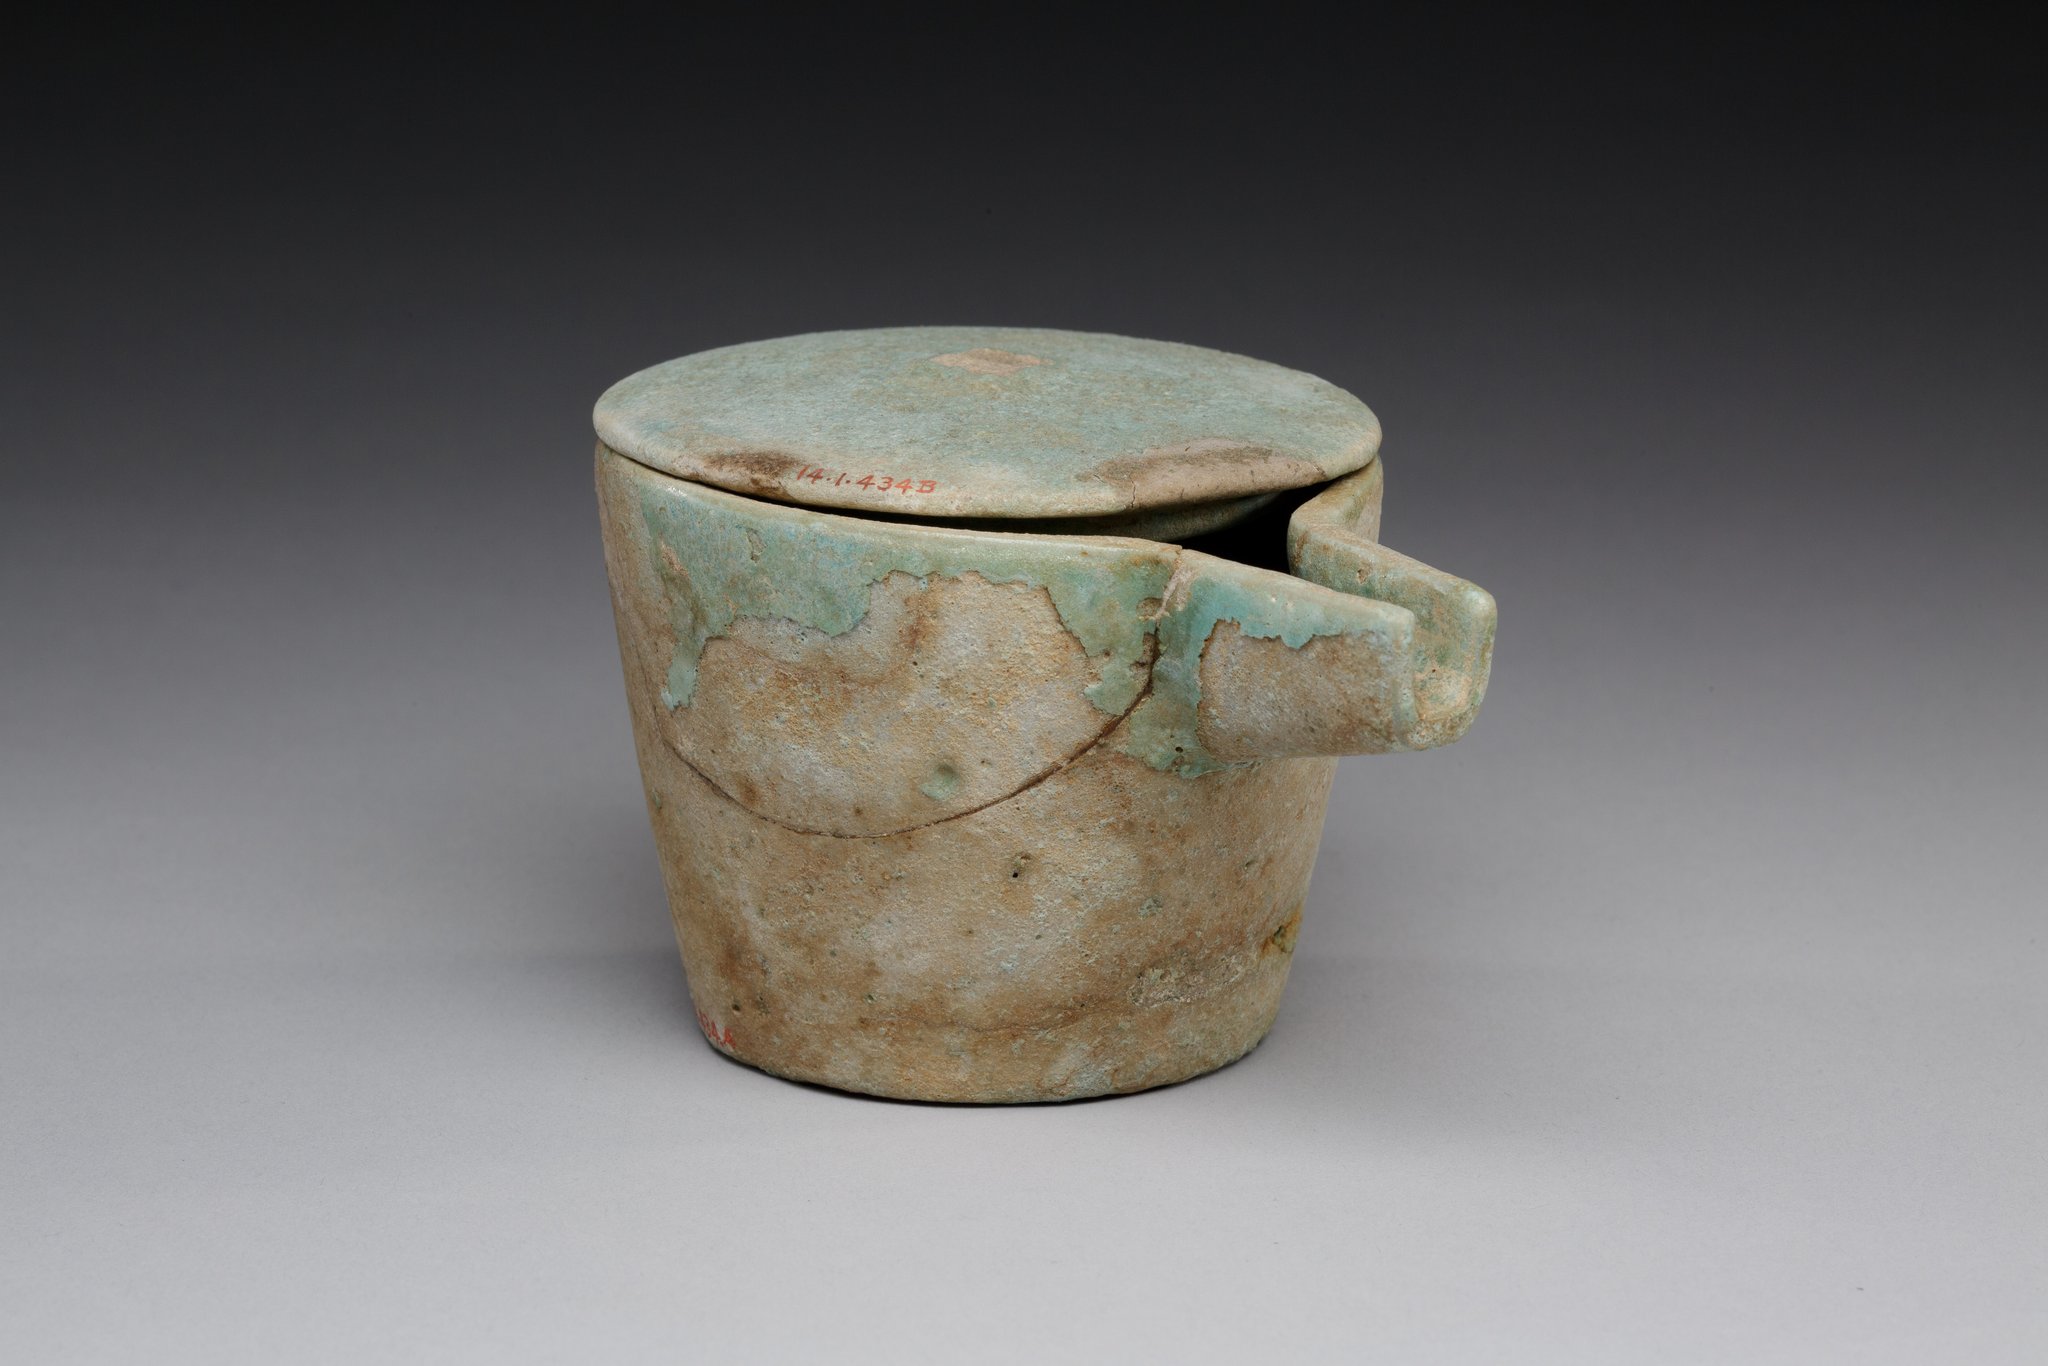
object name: cup with lid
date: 664-630 BCE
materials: faience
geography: egypt